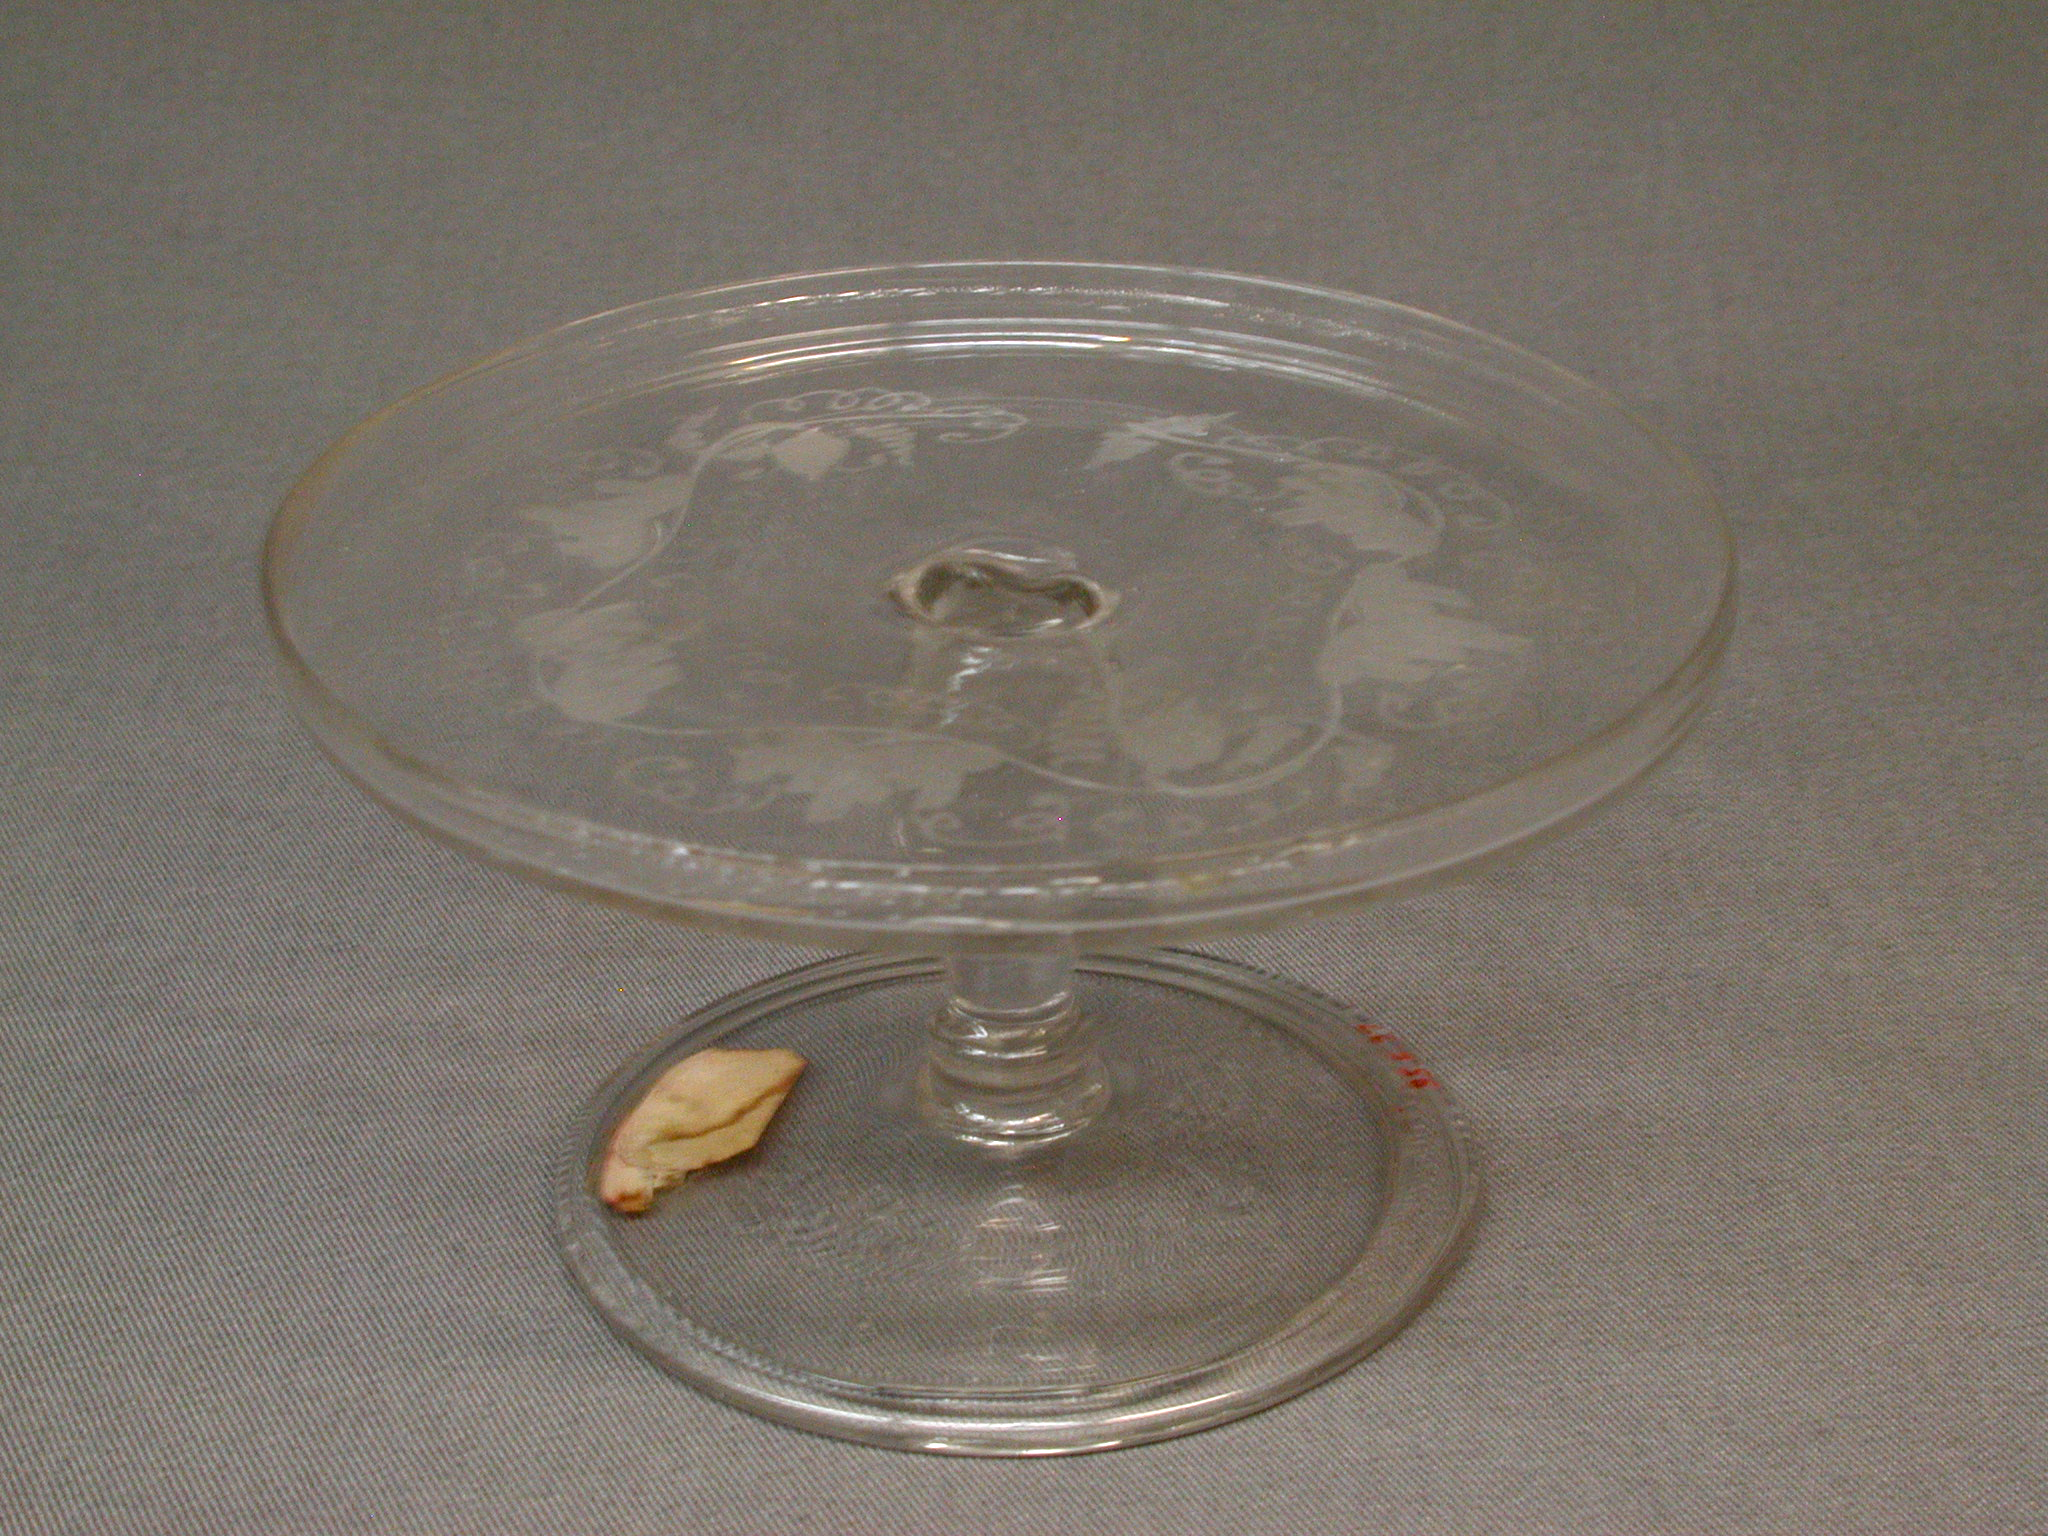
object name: tazza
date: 1701-1750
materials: glass